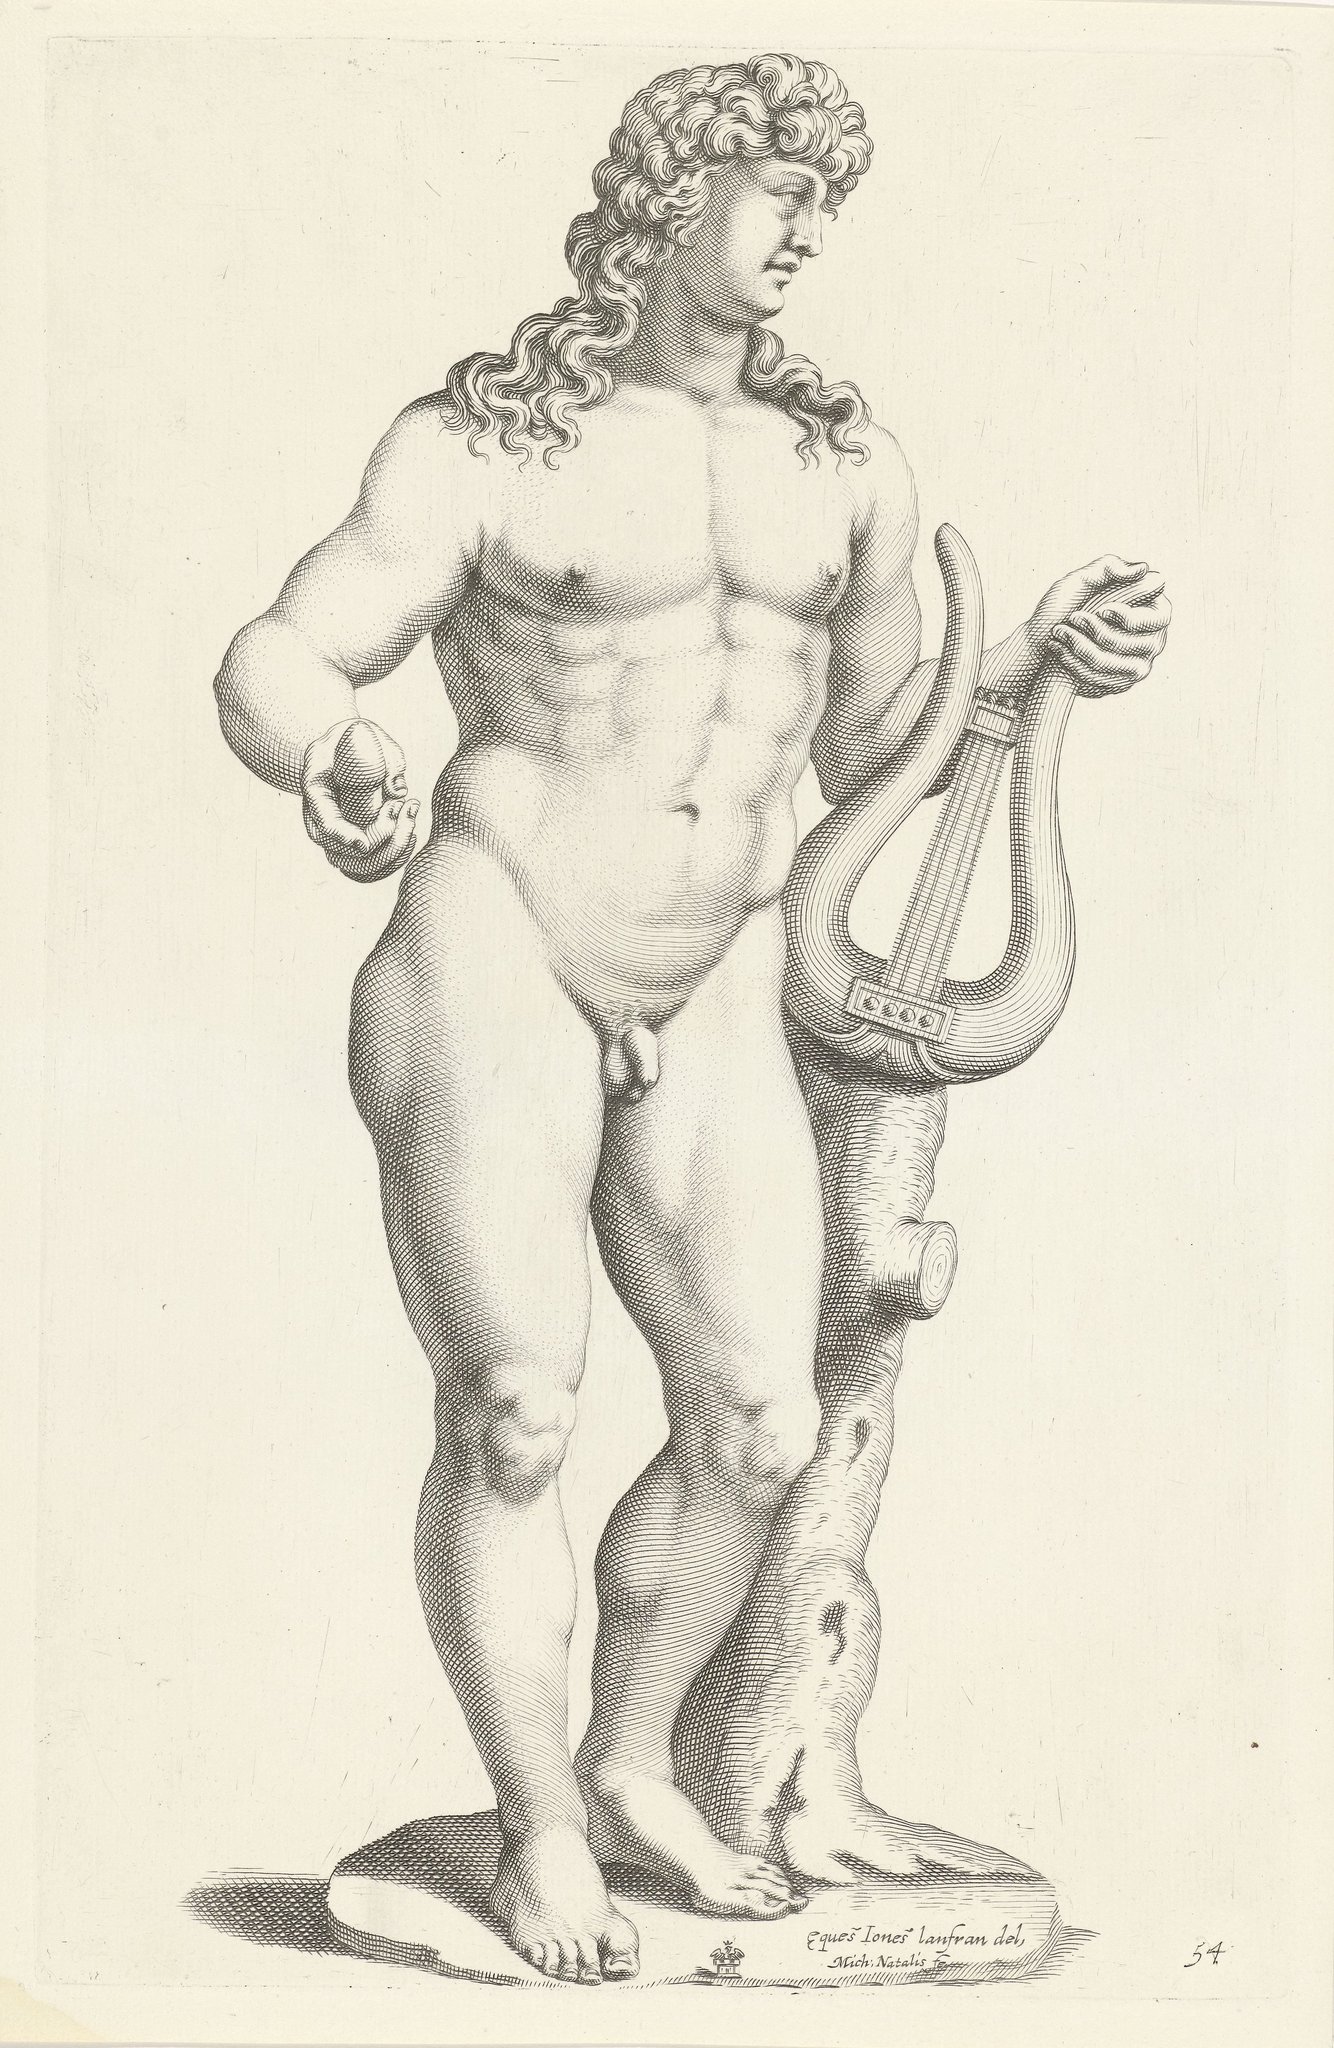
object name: print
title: Standbeeld van Apollo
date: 1640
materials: paper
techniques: engraving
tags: rome, vincenzo giustiniani (1564-1637), (story of) apollo (phoebus), piece of sculpture, reproduction of a piece of sculpture, monument, statue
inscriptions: collector's mark: Lugt 2228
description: Standbeeld van Apollo met de lier, staand naast een boomstam. Midden onder op de basis het wapenschild van Vincenzo Giustiniani. Prent uit een serie naar de sculpturen in de verzameling in de Galleria Giustiniani te Rome.